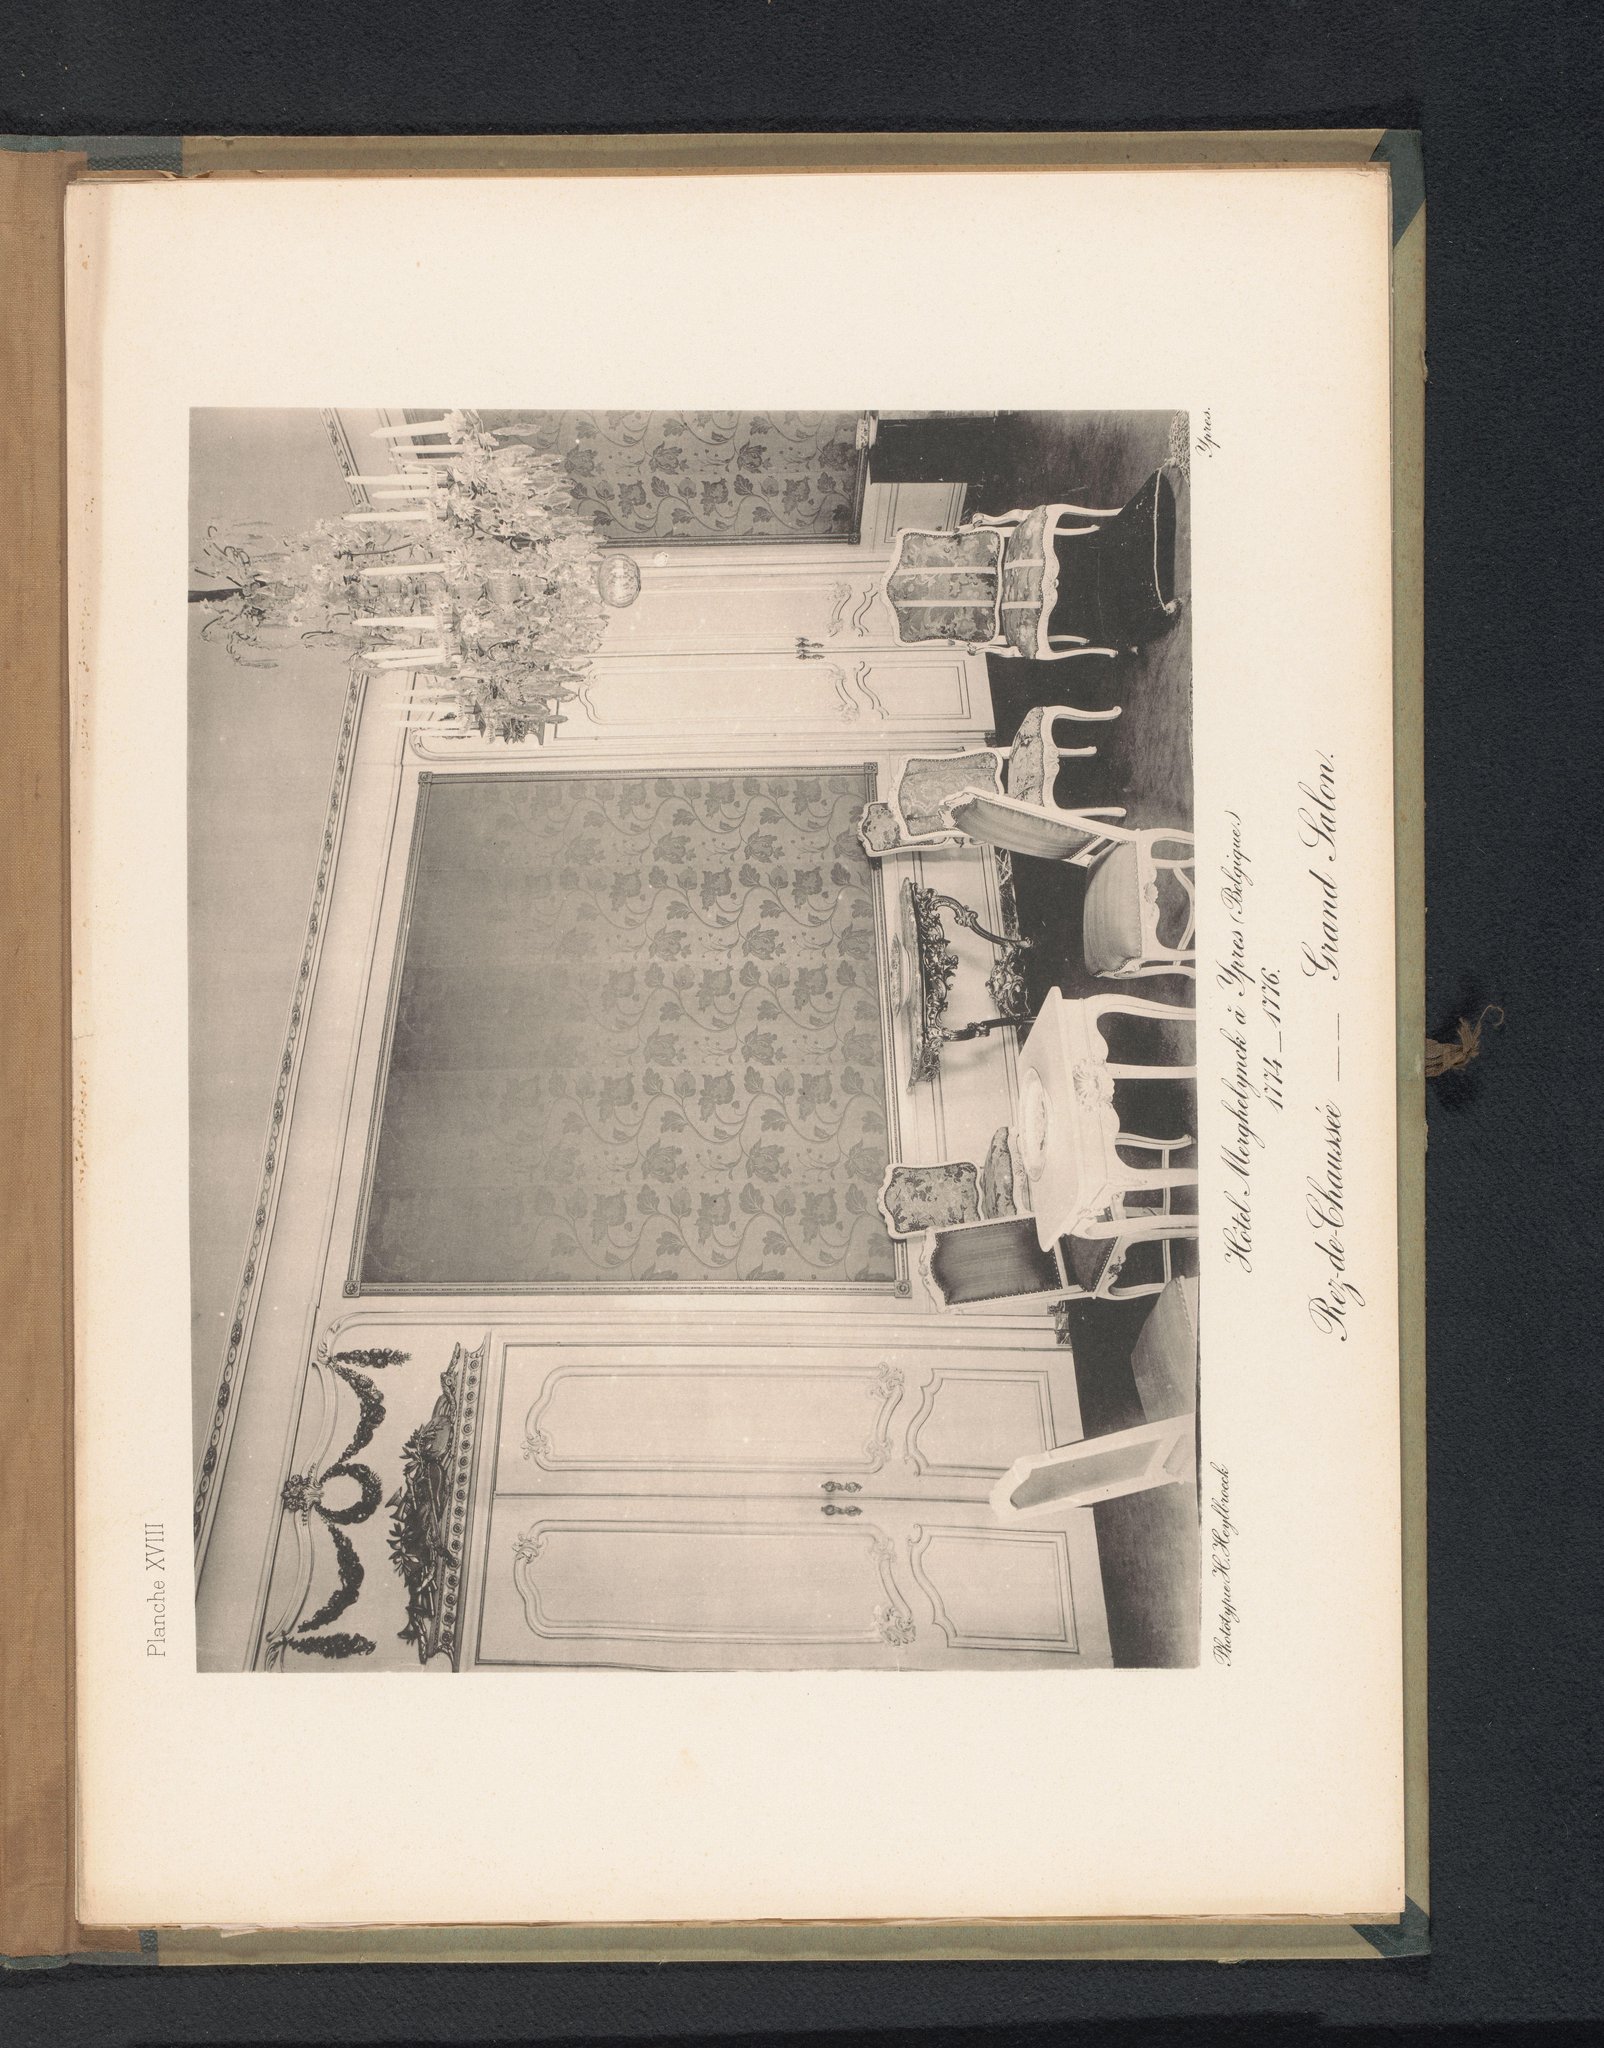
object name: photomechanical print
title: Hôtel Merghelynck à Ypres (Belgique) 1774-1776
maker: hector heylbroeck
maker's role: fotograaf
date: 1889-1894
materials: paper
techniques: photograph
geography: ieper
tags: living-room, parlour, sitting-room, hotel, hostelry, inn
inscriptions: number: ‘Planche XVIII’, inscription: ‘Ypres.’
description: Deze prent maakt deel uit van een omslag met 31 prenten en een katern met teksten.